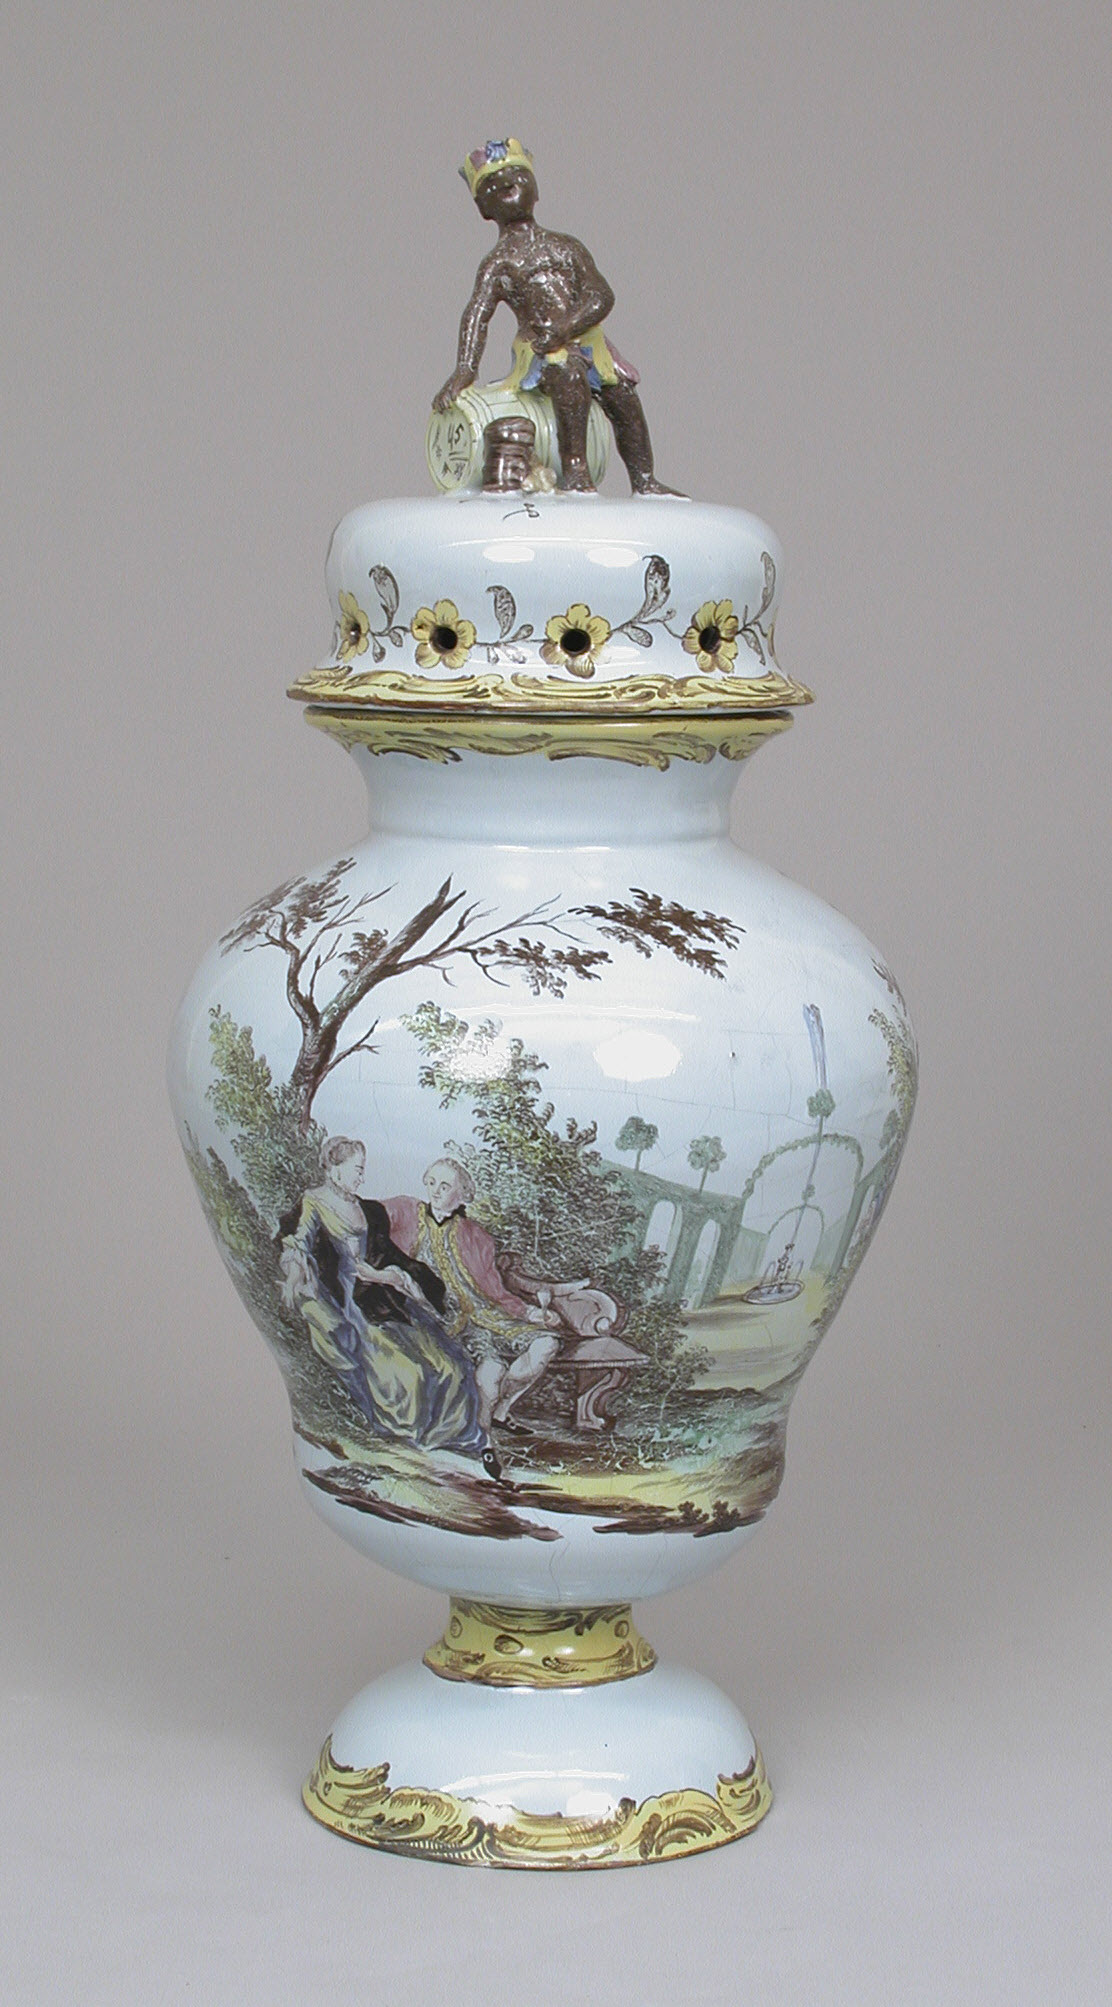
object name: potpourri vase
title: Potpourri vase with cover (one of a pair)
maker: abraham leihamer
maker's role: artist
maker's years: 1745-1774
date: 1772-1774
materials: earthenware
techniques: glazing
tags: couples,men,women